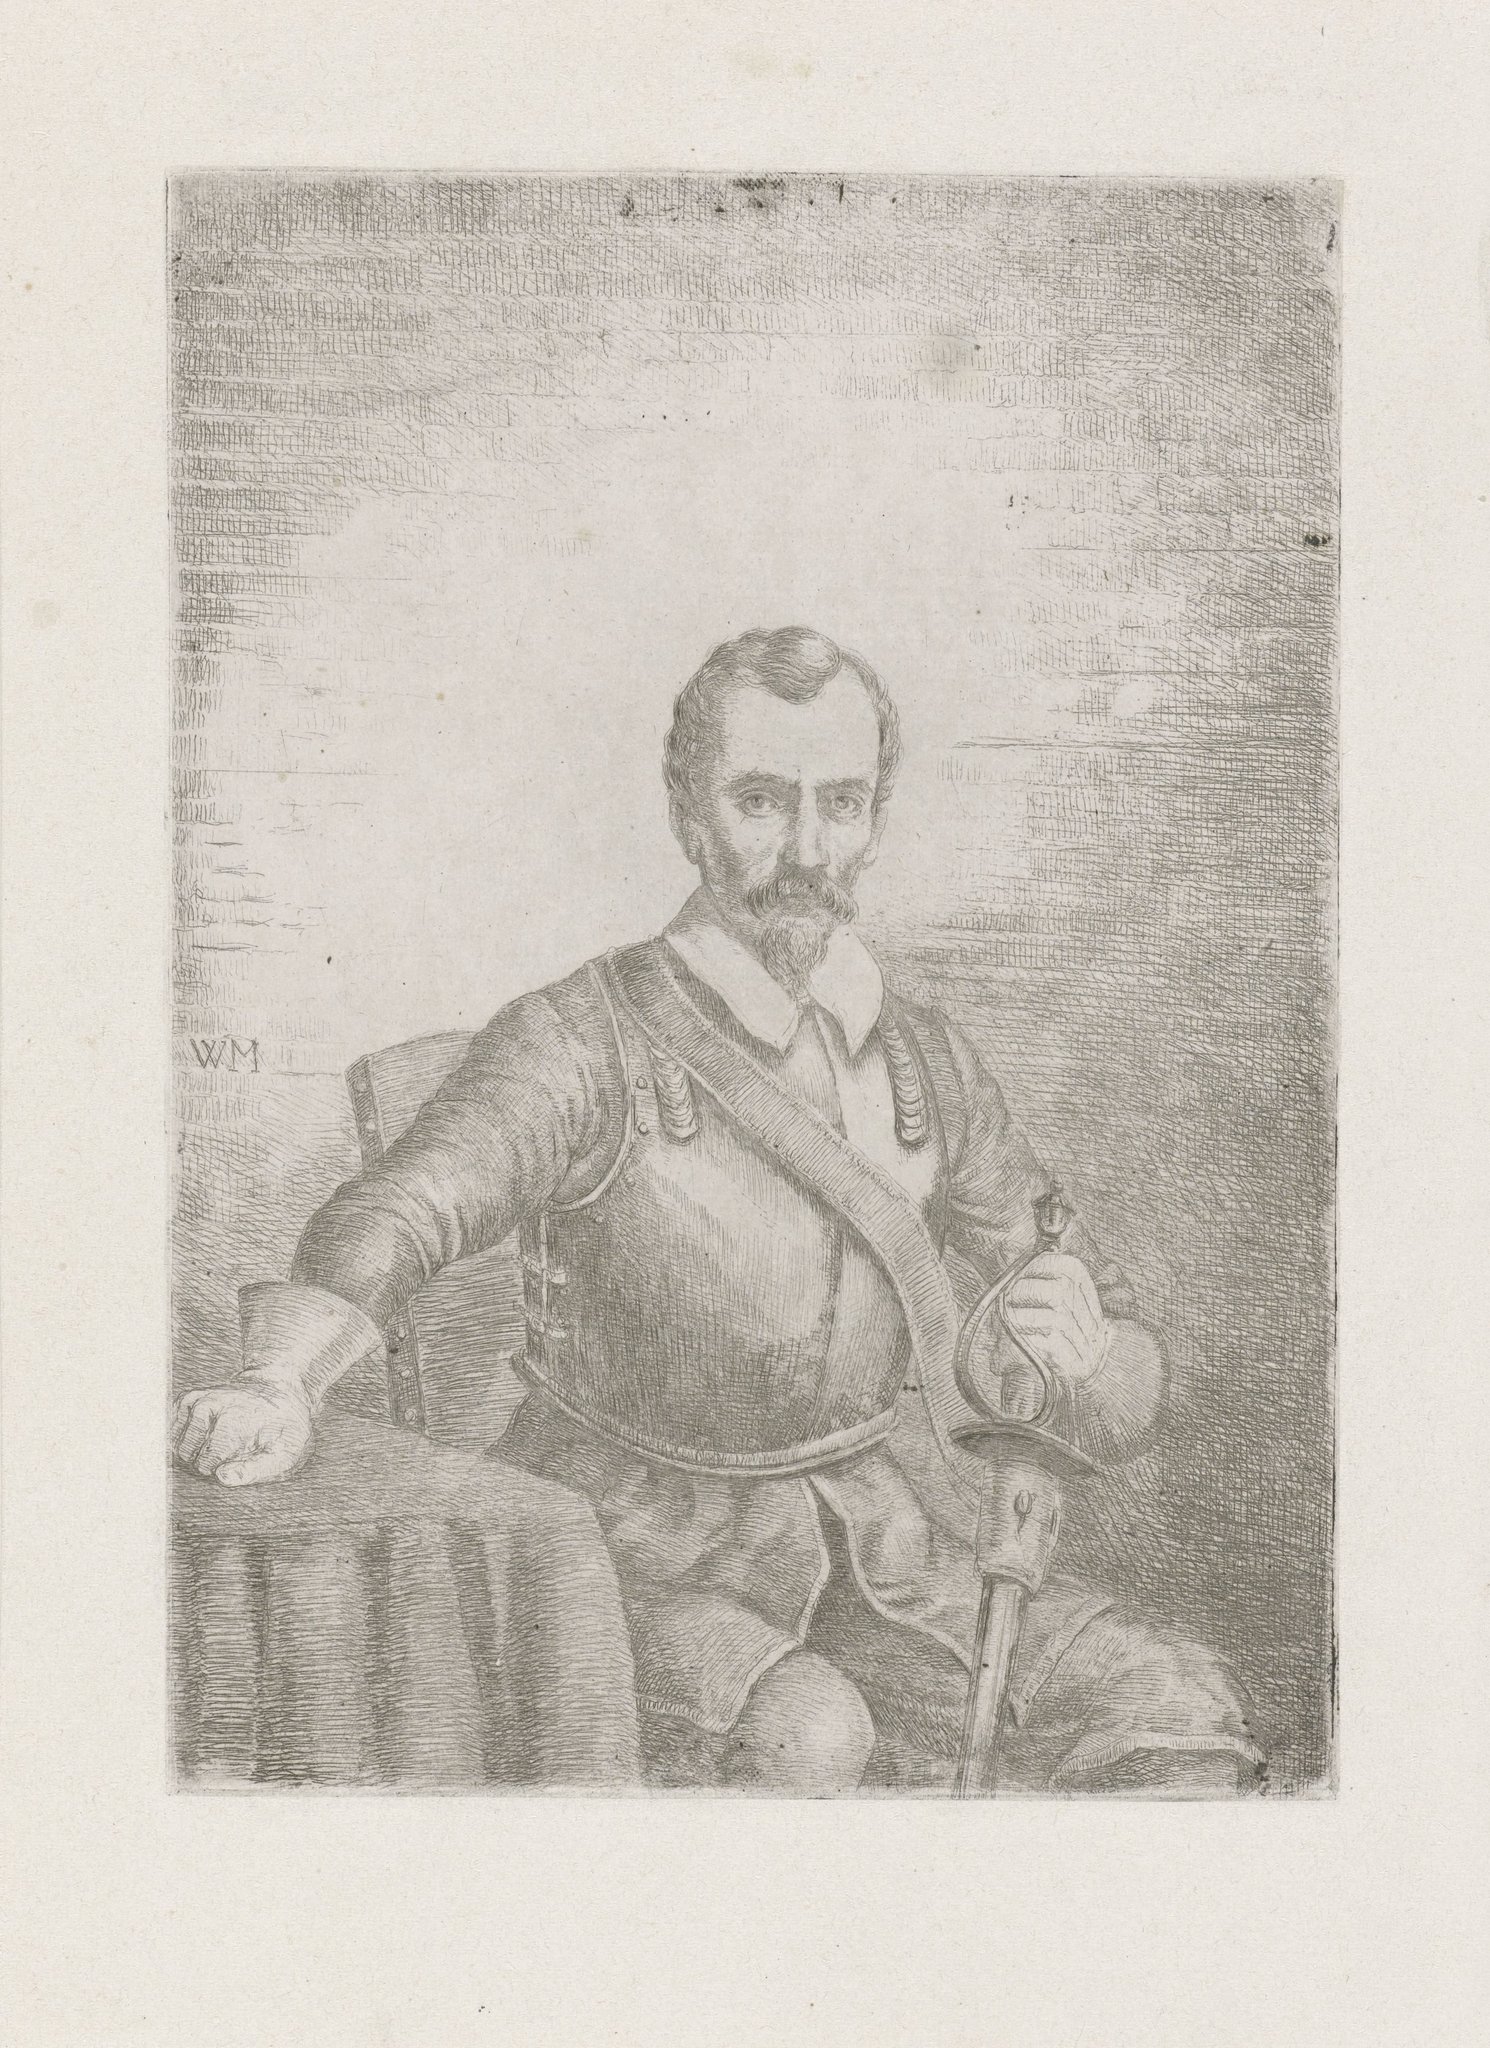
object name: print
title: Zittende man in harnas met zwaard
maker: christiaan wilhelmus moorrees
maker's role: draughtsman, print maker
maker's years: 1801-1867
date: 1811-1867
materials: paper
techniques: etching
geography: netherlands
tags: armour, hacking and thrusting weapons: sword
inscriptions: collector's mark: Lugt 2228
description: Een man, gekleed in harnas en in zijn hand het gevest van een zwaard, zit bij een tafel.